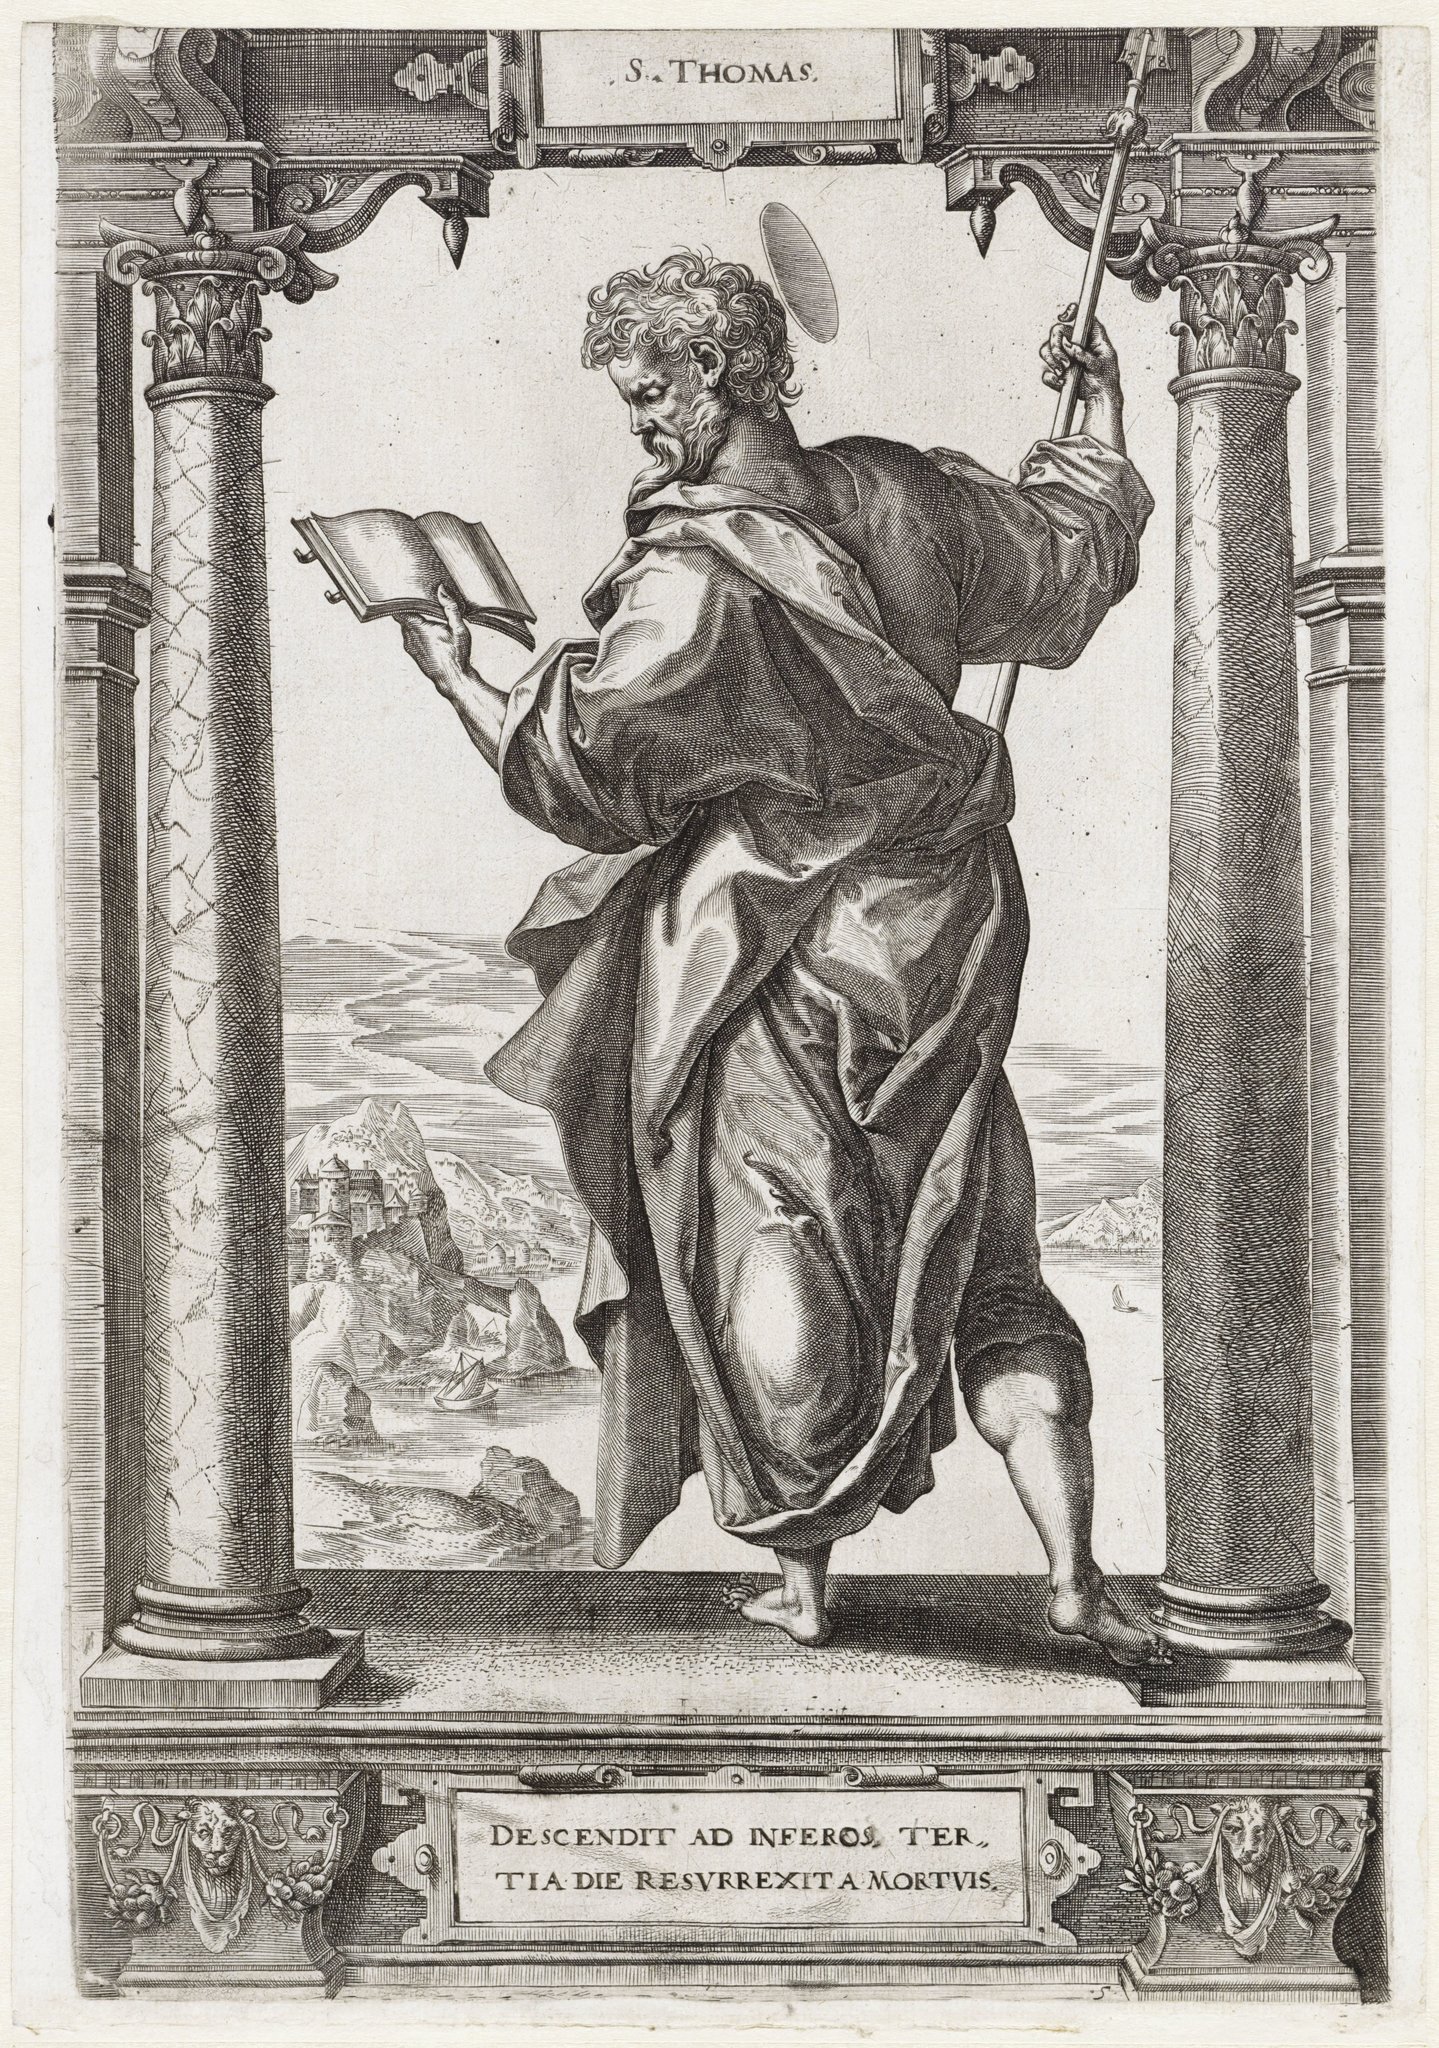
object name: print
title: Christus en de twaalf apostelen, en H. Paulus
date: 1578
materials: paper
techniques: engraving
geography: antwerp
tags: the apostle thomas; possible attributes: book, chalice, girdle, heart, lance or spear, scroll, square, stones, column, pillar ~ architecture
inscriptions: collector's mark: Lugt 2760, collector's mark: Lugt 2228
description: De heilige Tomas staat, op de rug gezien, tussen twee zuilen in een architecturale omlijsting. In zijn ene hand houdt hij een opengeslagen boek, in zijn andere hand een speer. Op de achtergrond een gezicht op een rivier en een heuvelachtig landschap. In het kader onderaan een tweeregelig onderschrift in het Latijn.